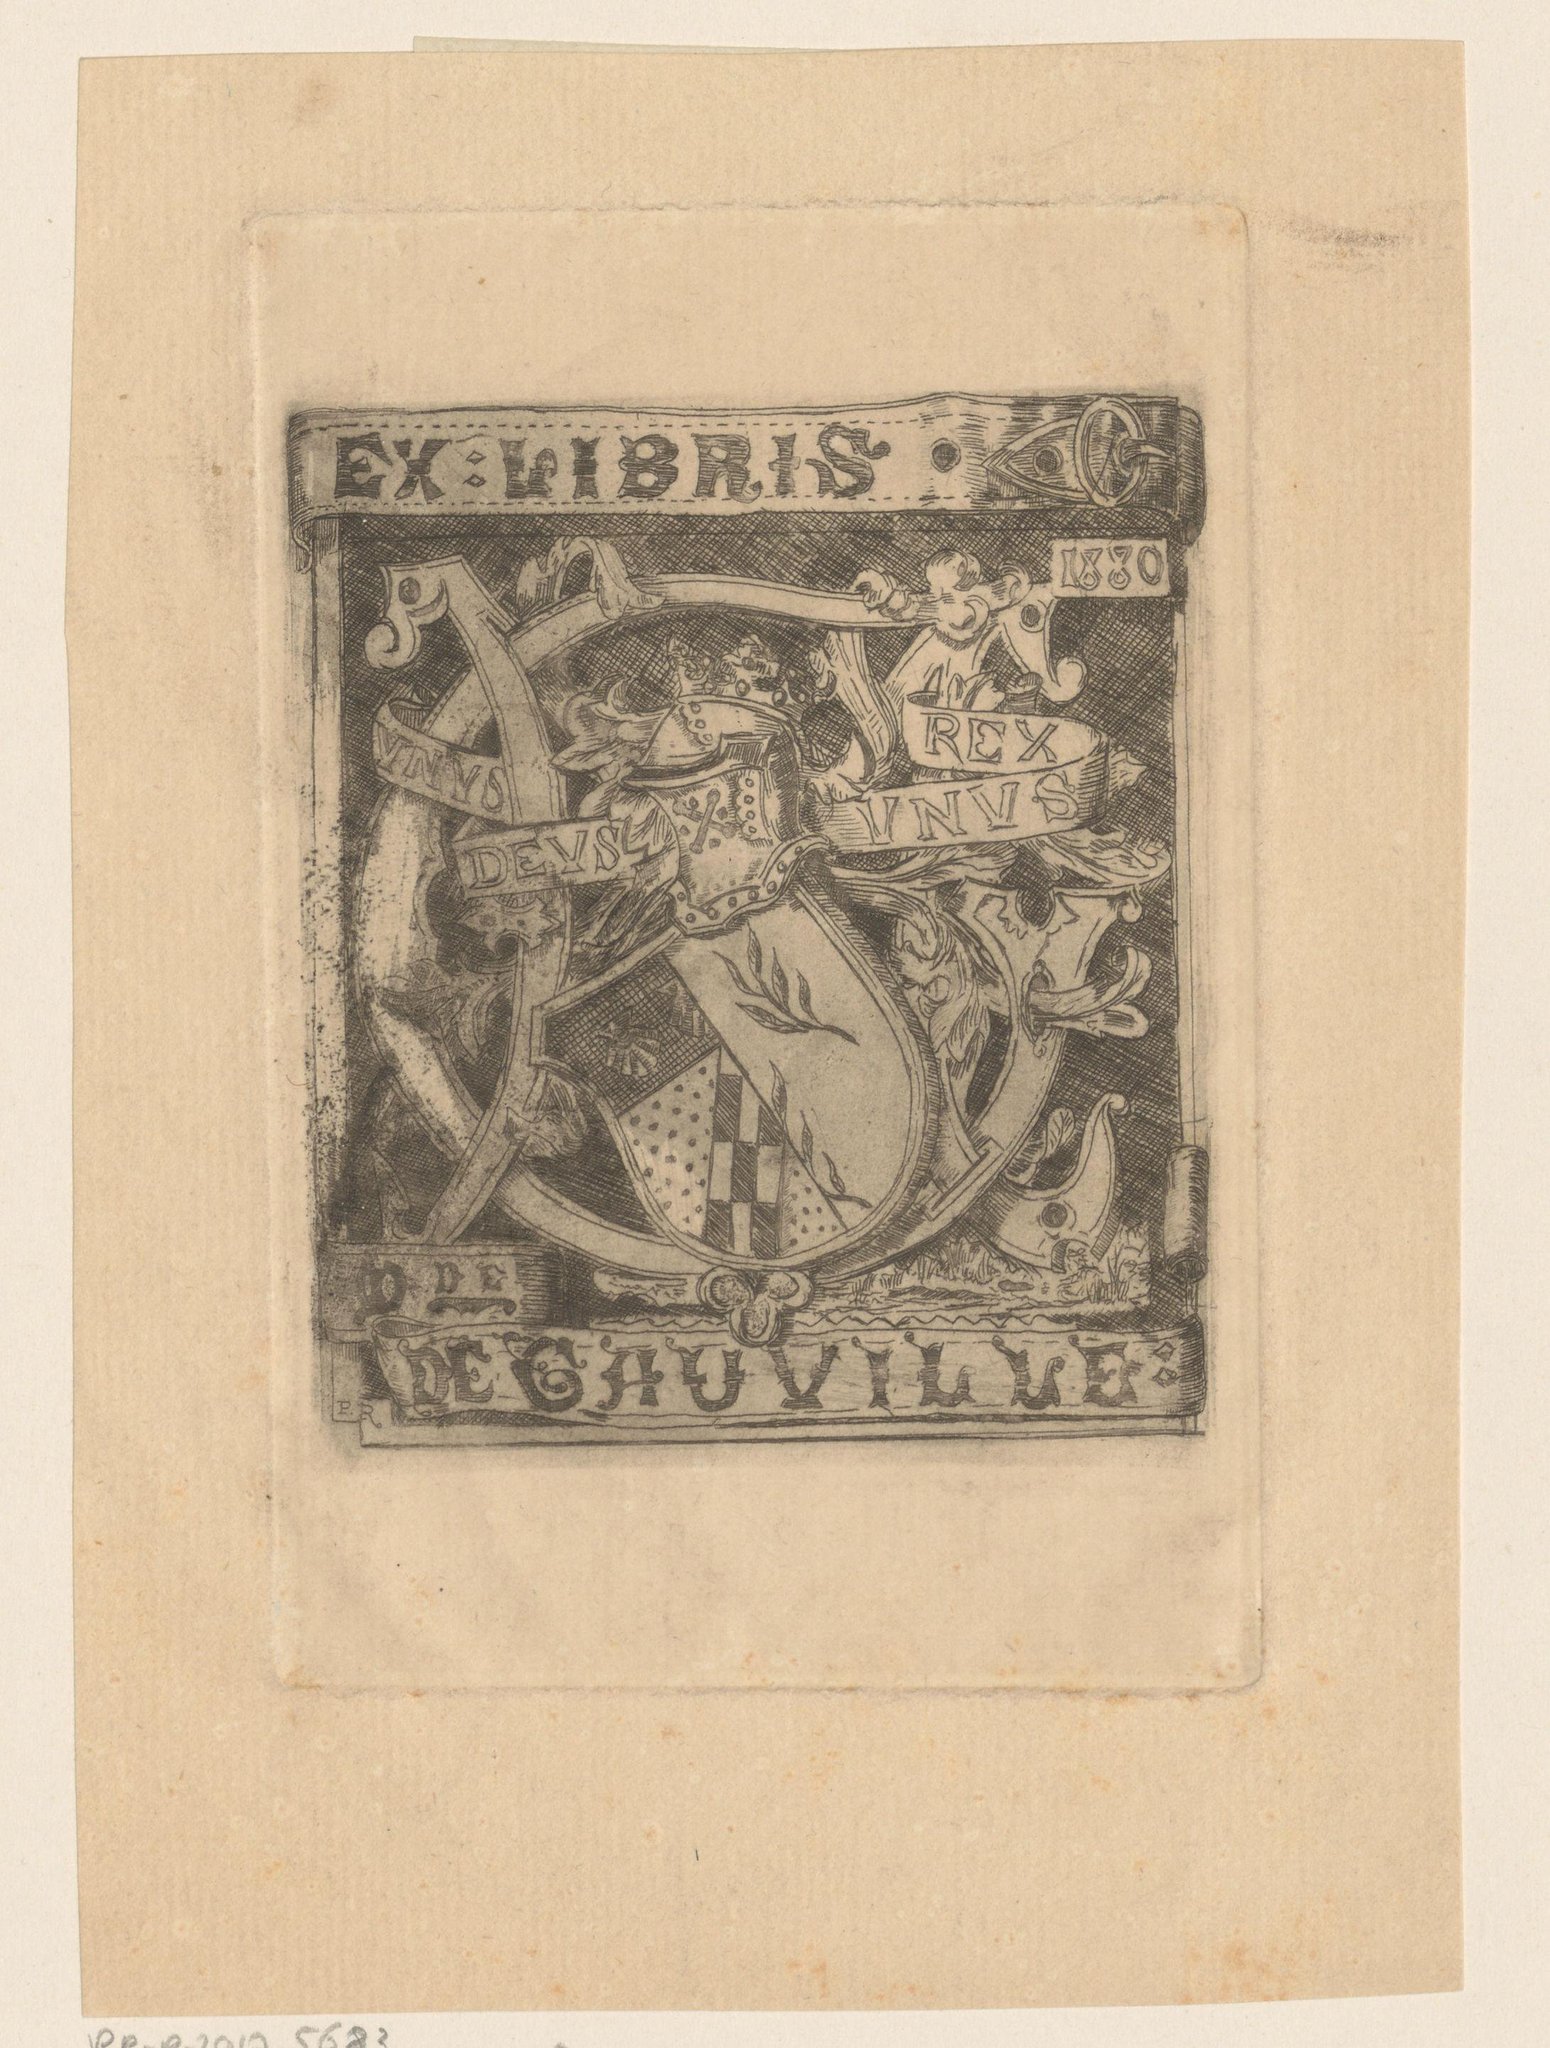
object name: bookplate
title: Ex libris van [...] De Gauville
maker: p. riera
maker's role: print maker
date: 1880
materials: paper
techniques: etching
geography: france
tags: armorial bearing, heraldry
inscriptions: date